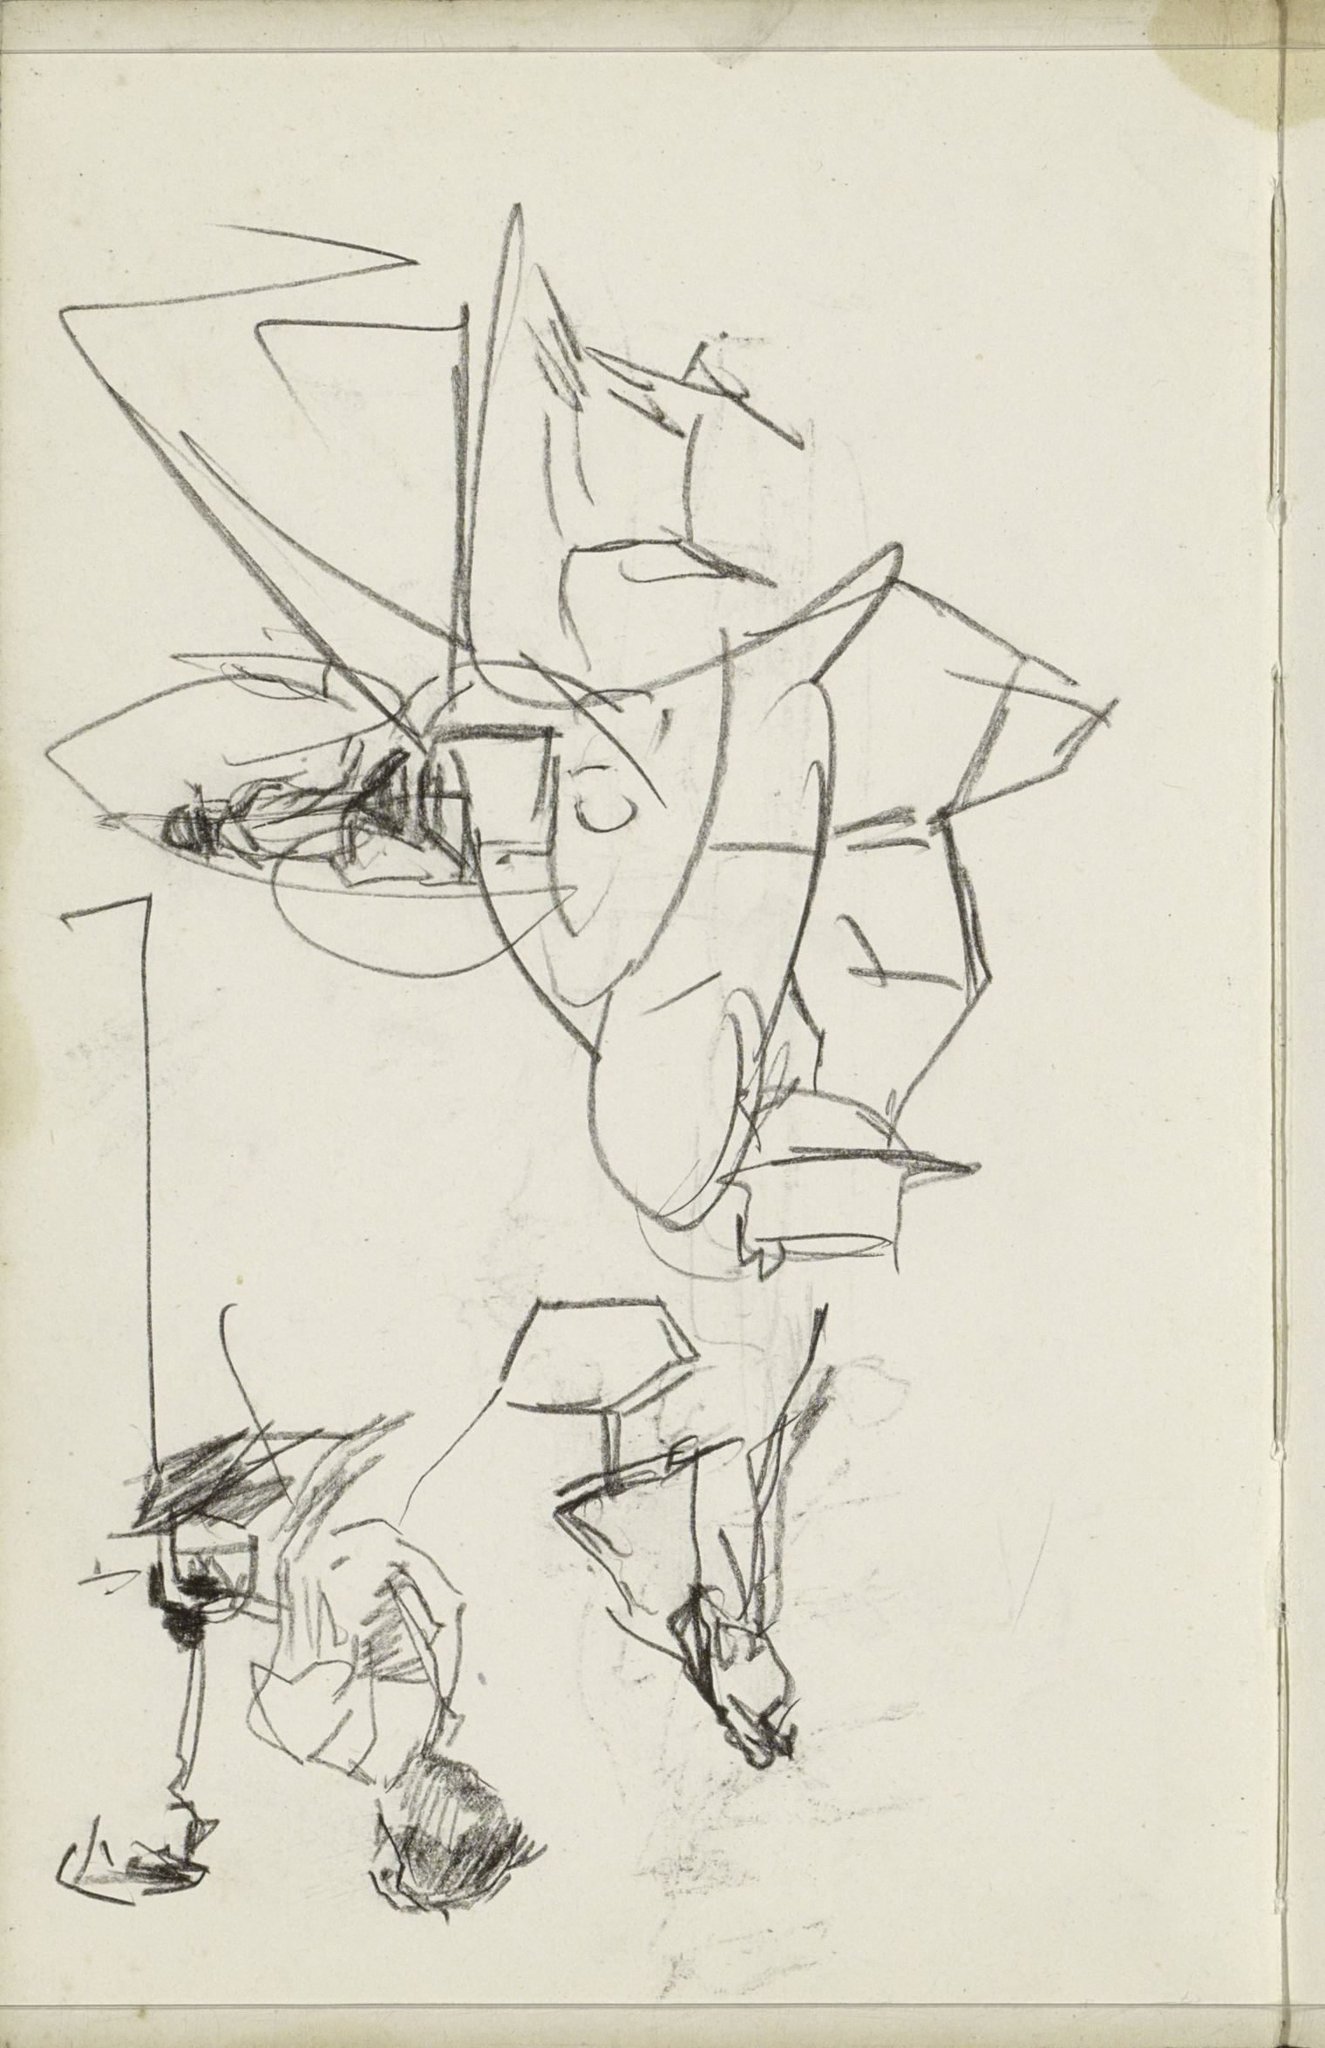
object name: sketchbook leaf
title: Figuurstudies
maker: isaac israels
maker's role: draughtsman, painter, print maker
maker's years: 1865-1934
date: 1875-1934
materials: chalk, paper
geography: london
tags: postures of the human figure, postures of the human figure - aa - female human figure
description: Pagina 21 en pagina 22 uit schetsboek XXXV met 36 pagina's.